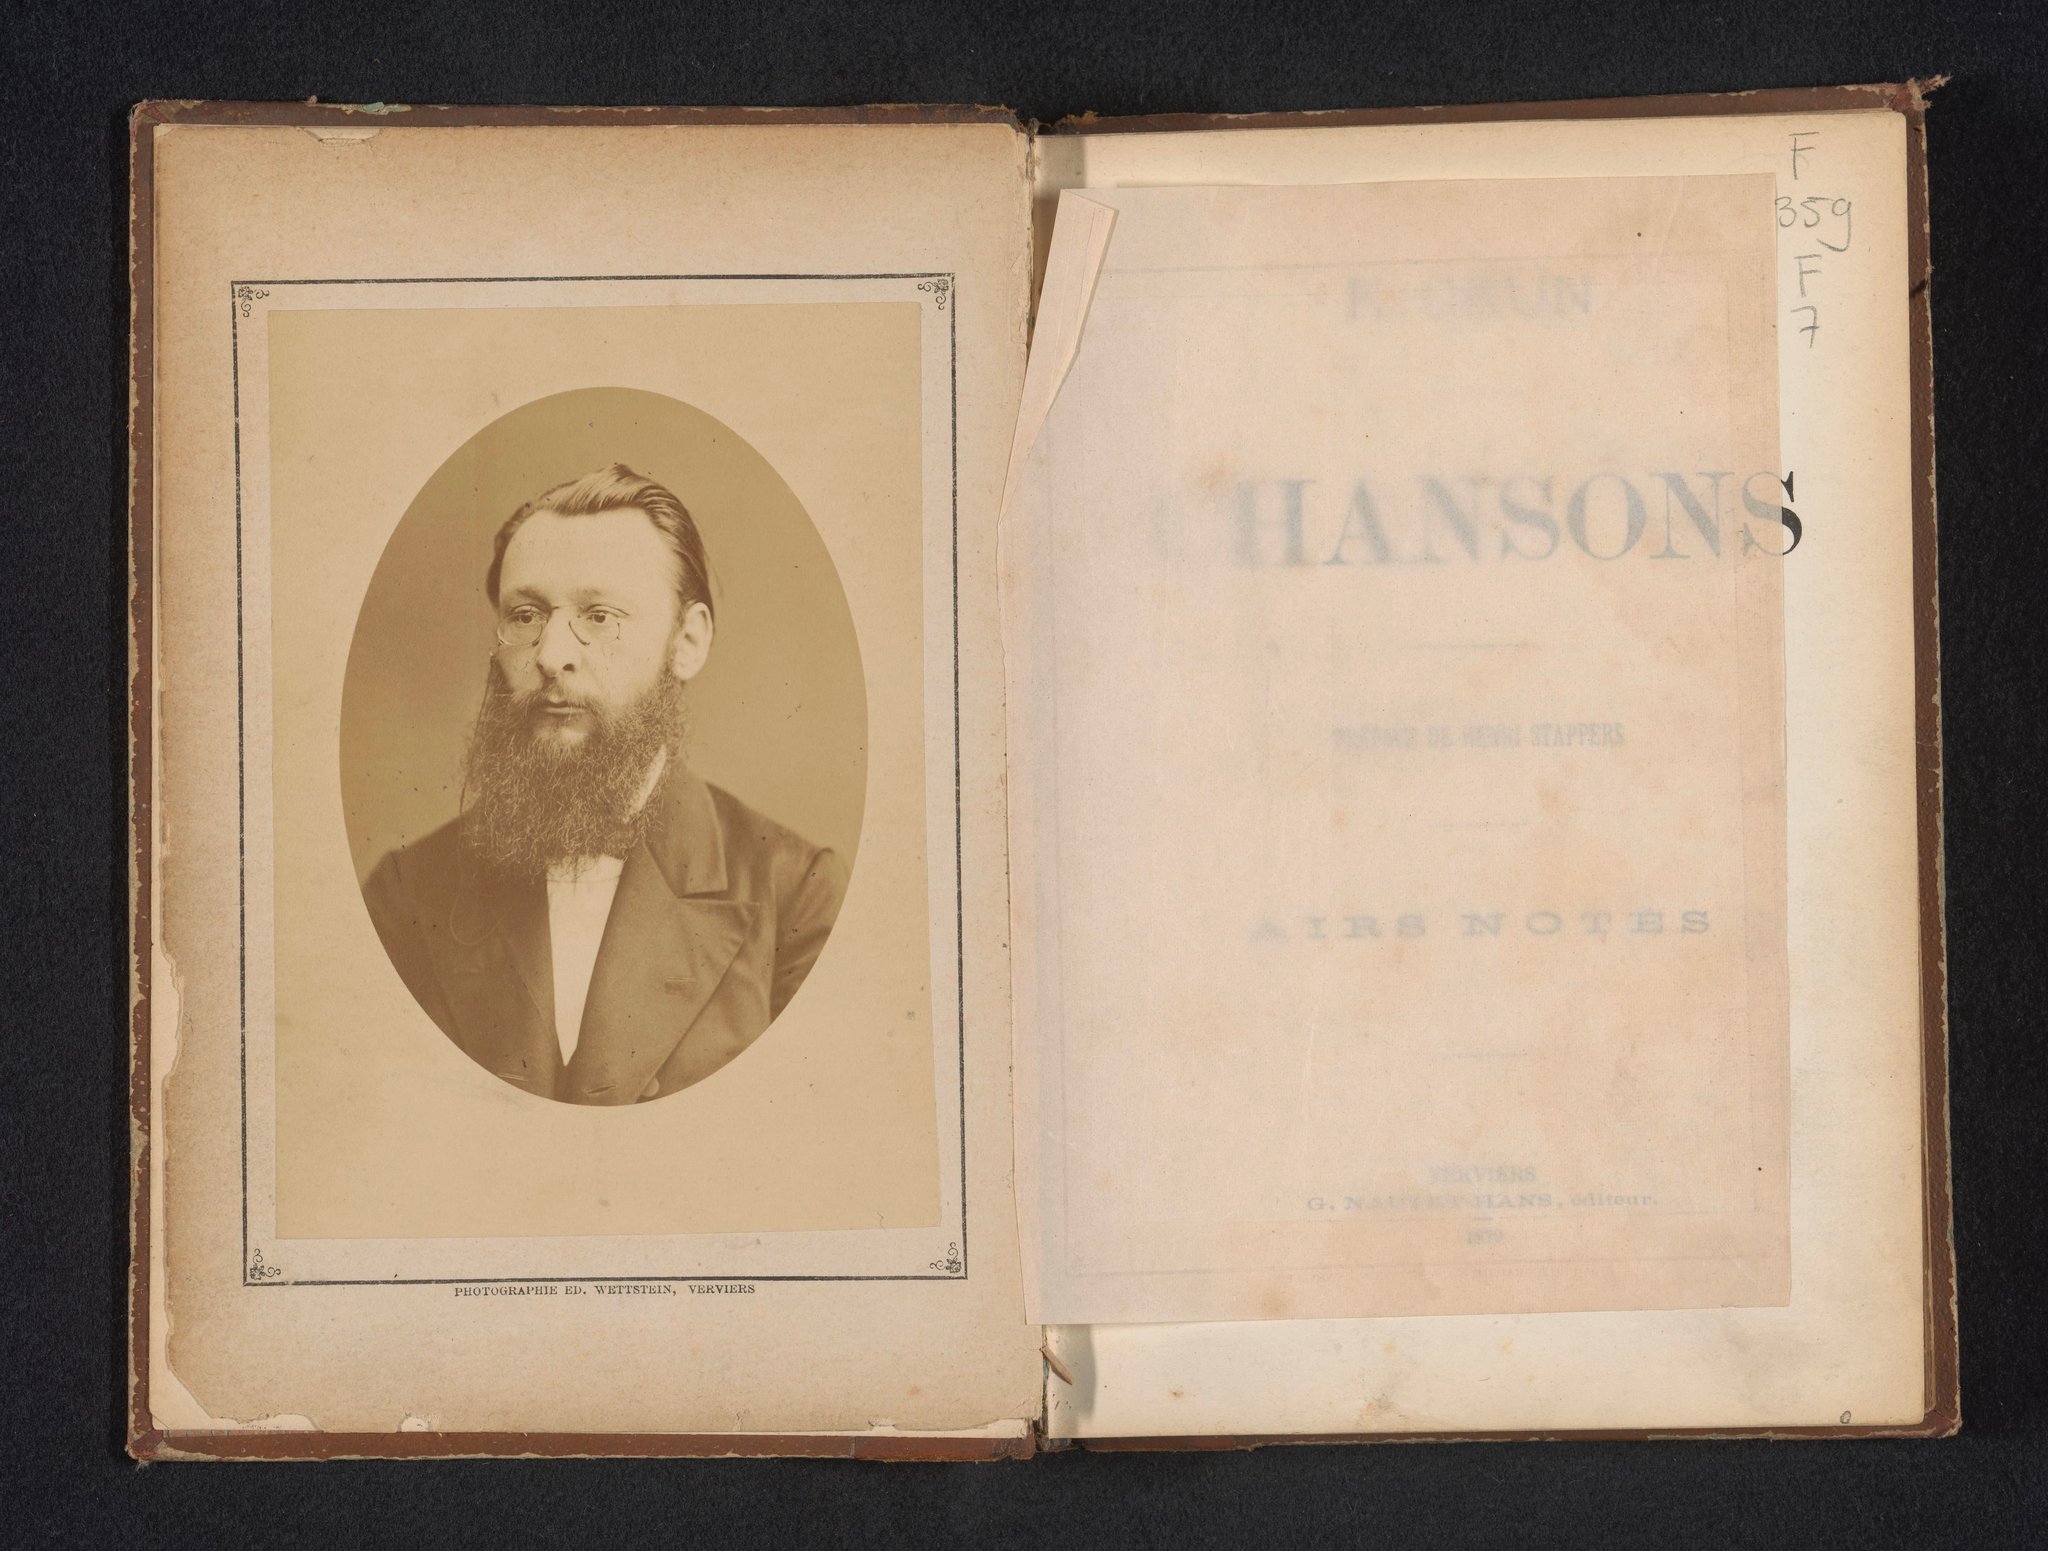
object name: page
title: Portret van Karl Grün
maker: jean edouard wettstein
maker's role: fotograaf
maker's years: 1839-1899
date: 1874-1879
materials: photographic support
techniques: albumen print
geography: verviers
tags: vienna, politician, karl grün, historical persons